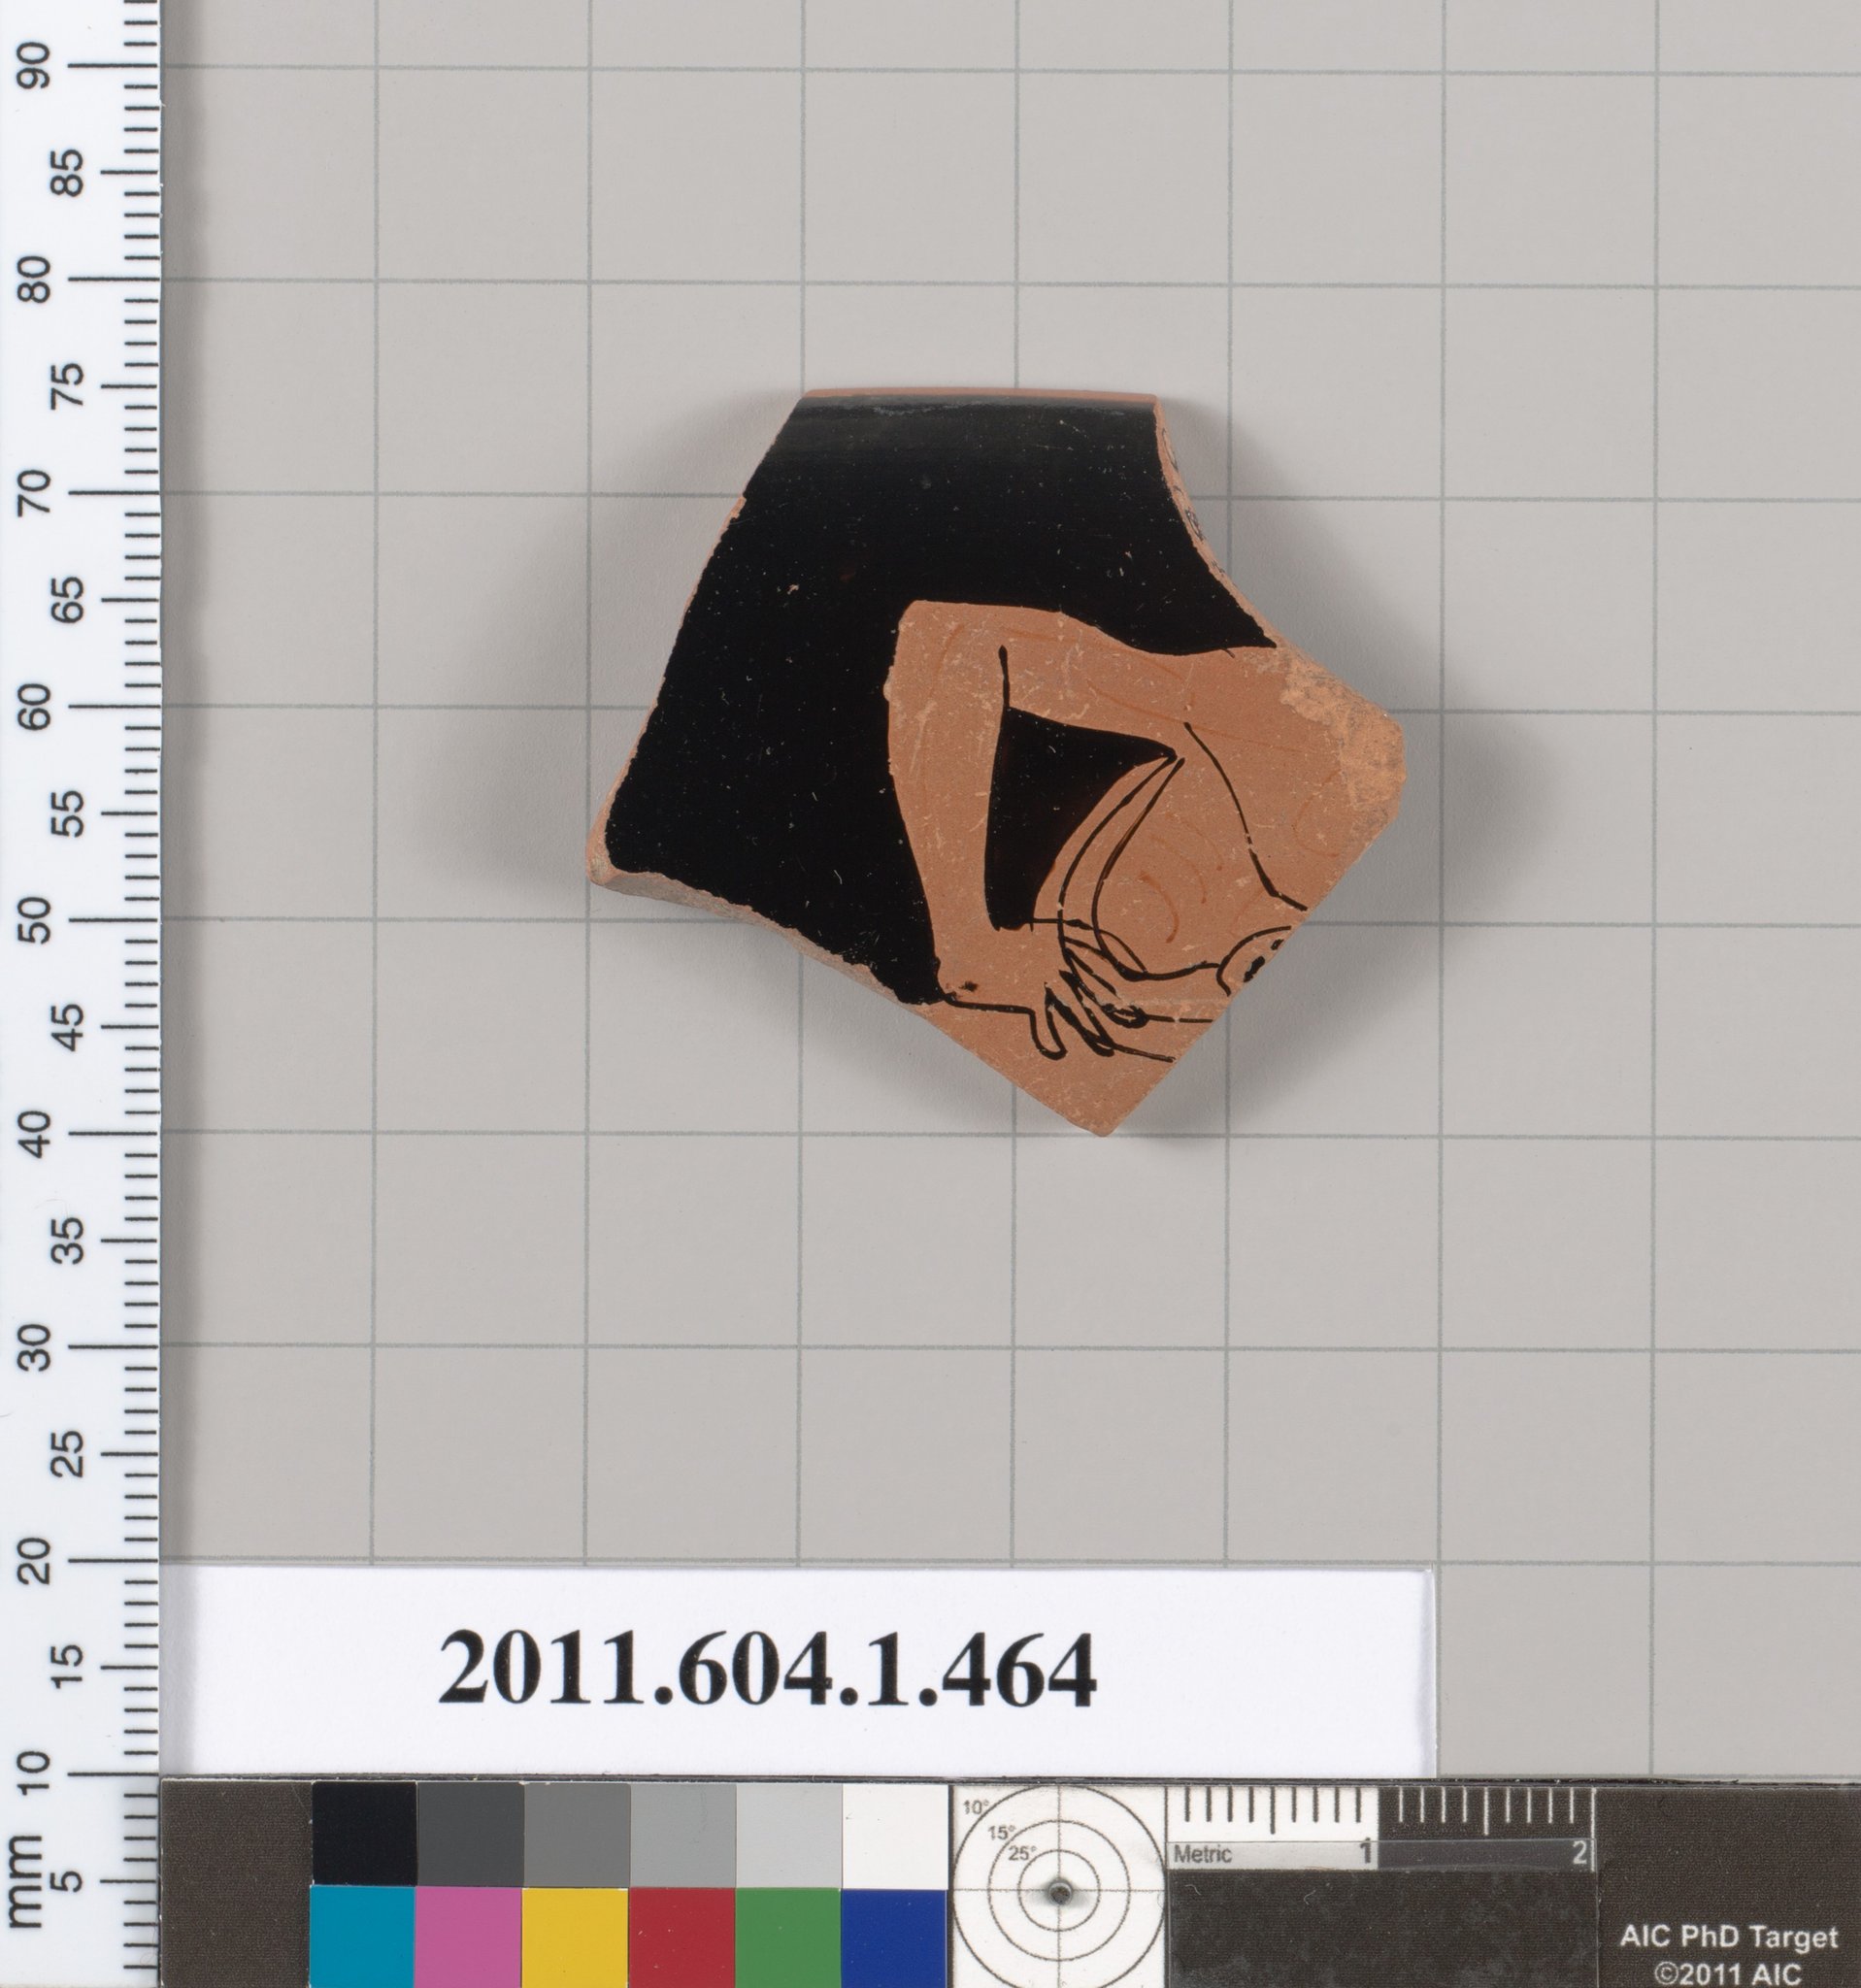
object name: kylix fragment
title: Terracotta rim fragment of a kylix (drinking cup)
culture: greek, attic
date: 490-480 BCE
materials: terracotta